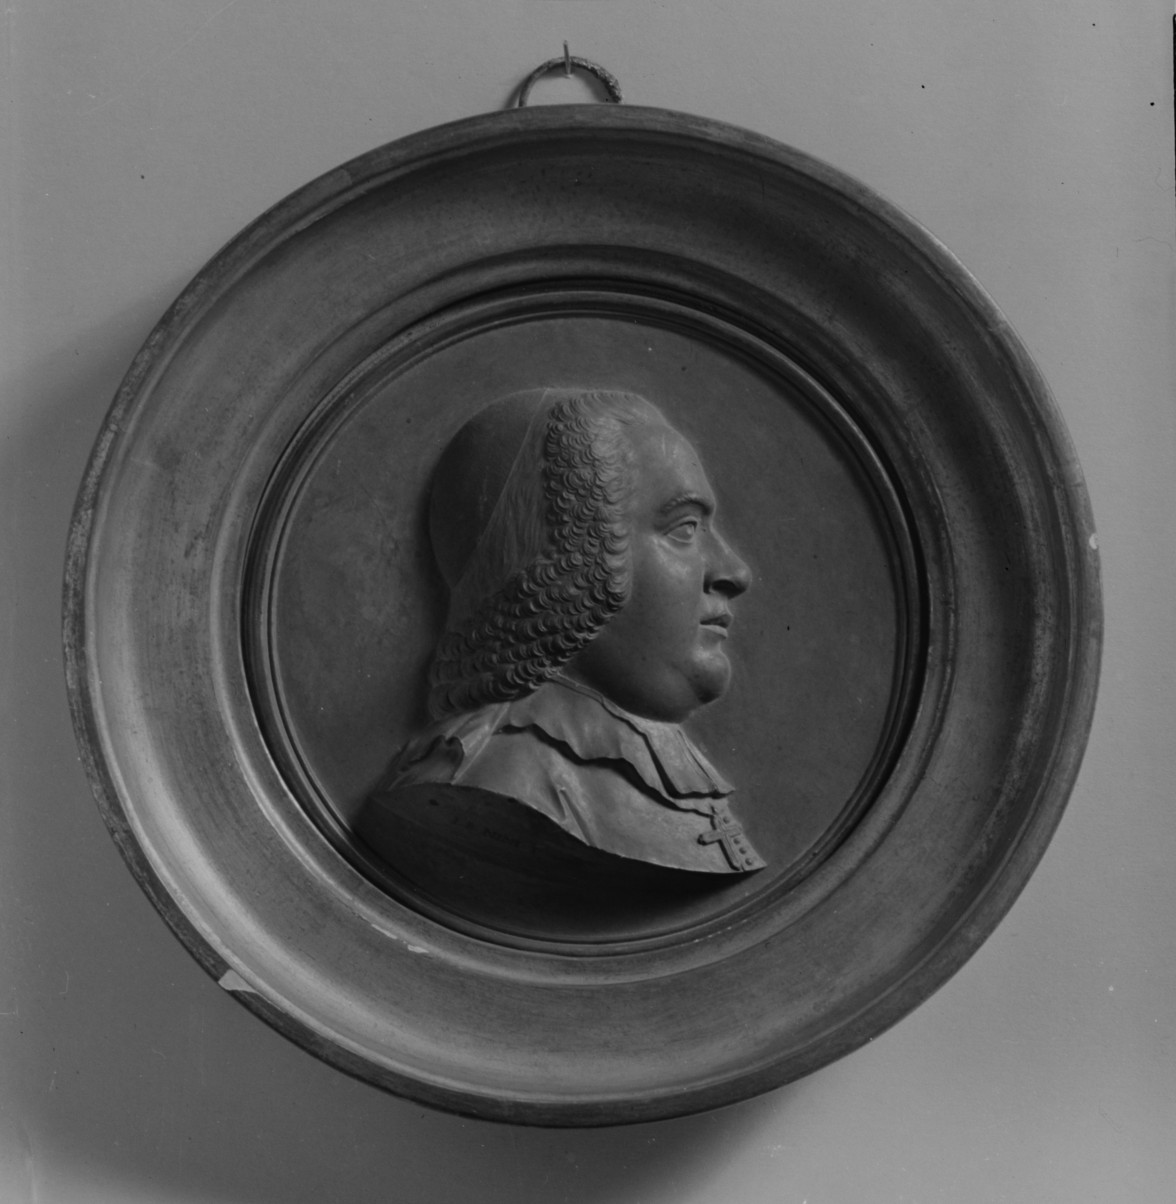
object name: medallion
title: Portrait of an ecclesiastic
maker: jean-baptiste nini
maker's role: artist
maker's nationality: italian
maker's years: 1717-1786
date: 1765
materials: gilt, terracotta, wood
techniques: casting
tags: men,profiles